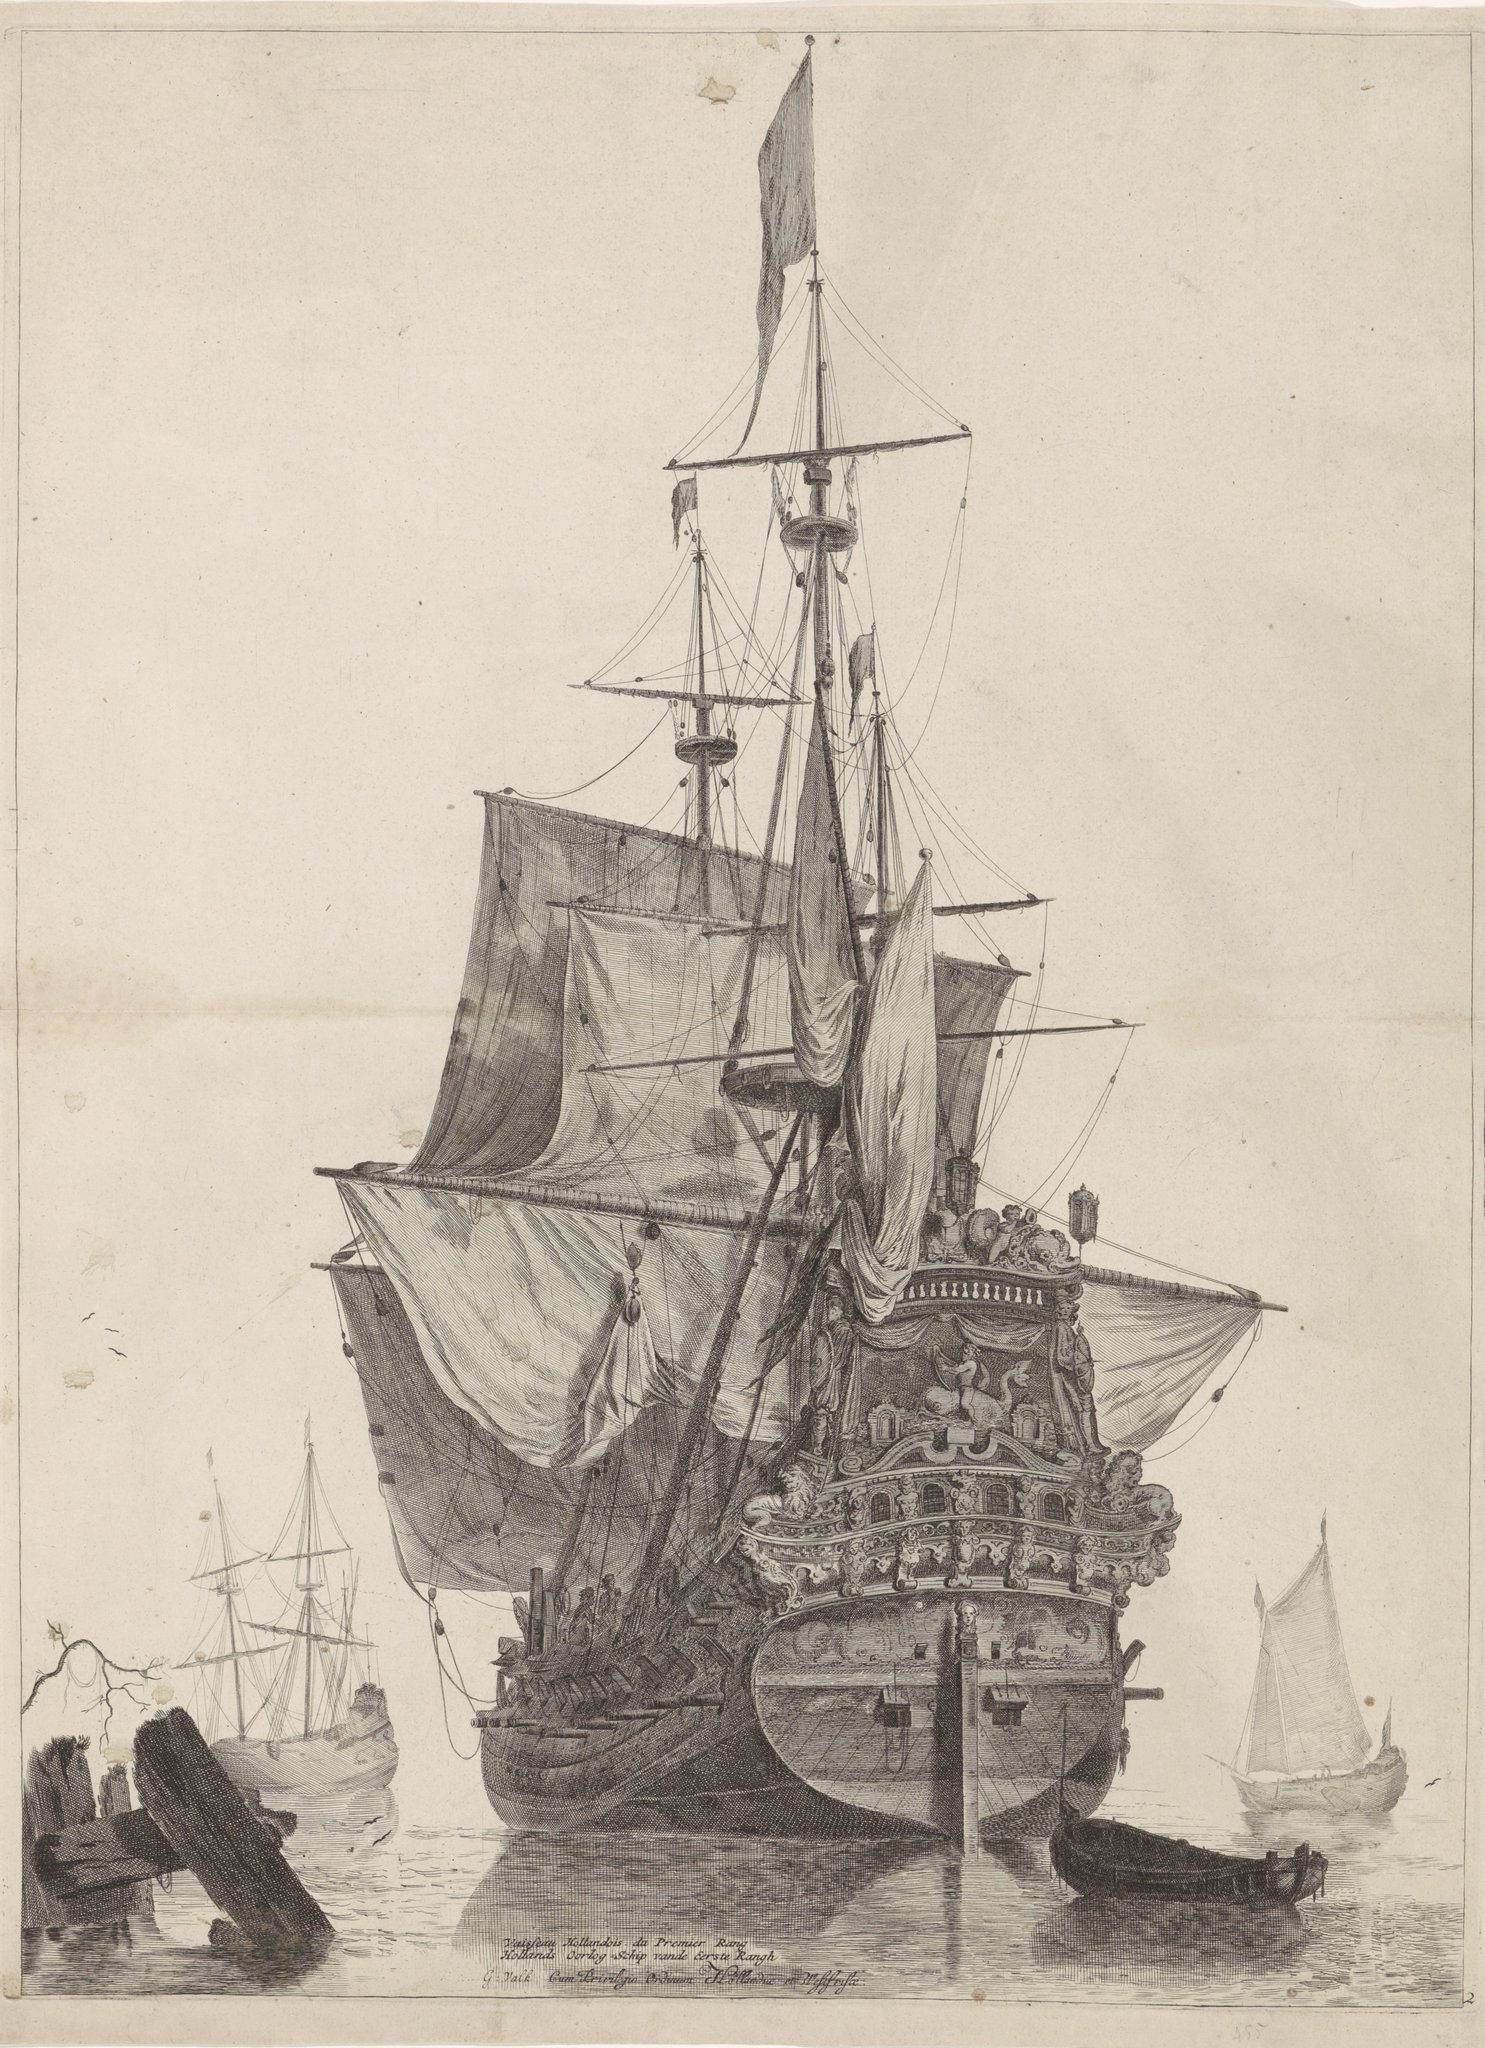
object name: print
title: Nederlands oorlogschip gezien op de spiegel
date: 1670-1726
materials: paper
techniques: engraving, etching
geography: amsterdam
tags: sailing-ship, sailing-boat, arion rides on a dolphin, holding his lyre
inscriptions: collector's mark: Lugt 2228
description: Nederlands eersterangs oorlogschip, op de spiegel gezien. Op de spiegel Arion op de dolfijn.